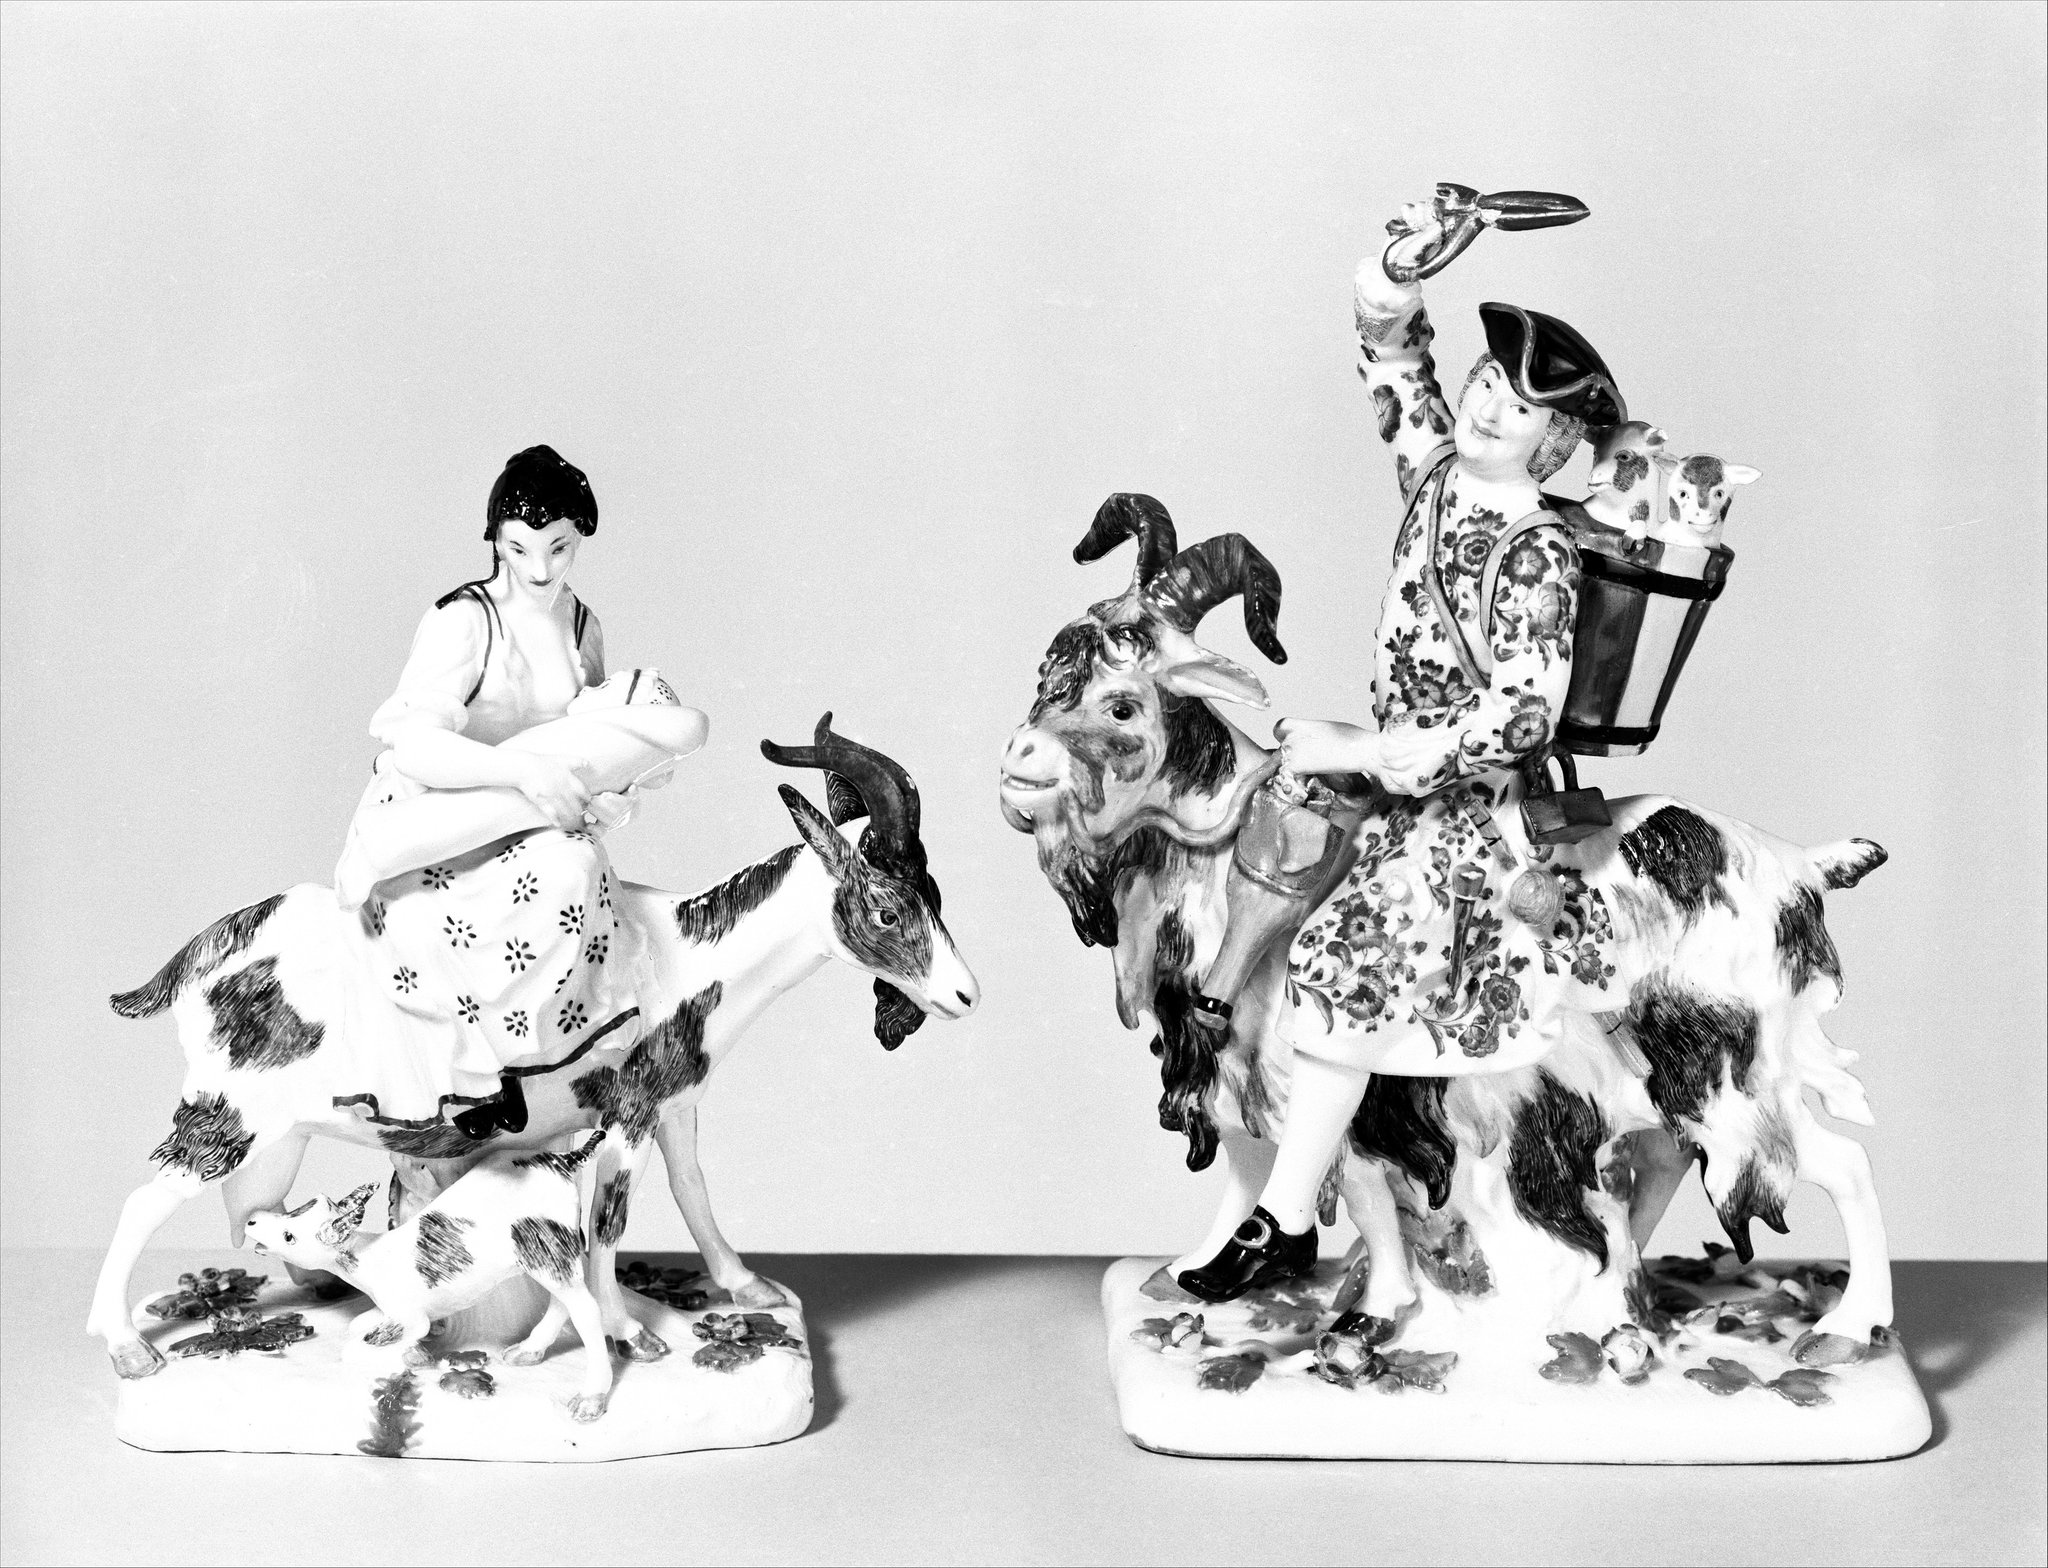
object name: group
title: Tailor riding a goat (one of a pair)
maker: meissen manufactory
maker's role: manufactory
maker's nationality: german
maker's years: 1710-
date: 1740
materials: hard paste porcelain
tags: infants,men,women,goats